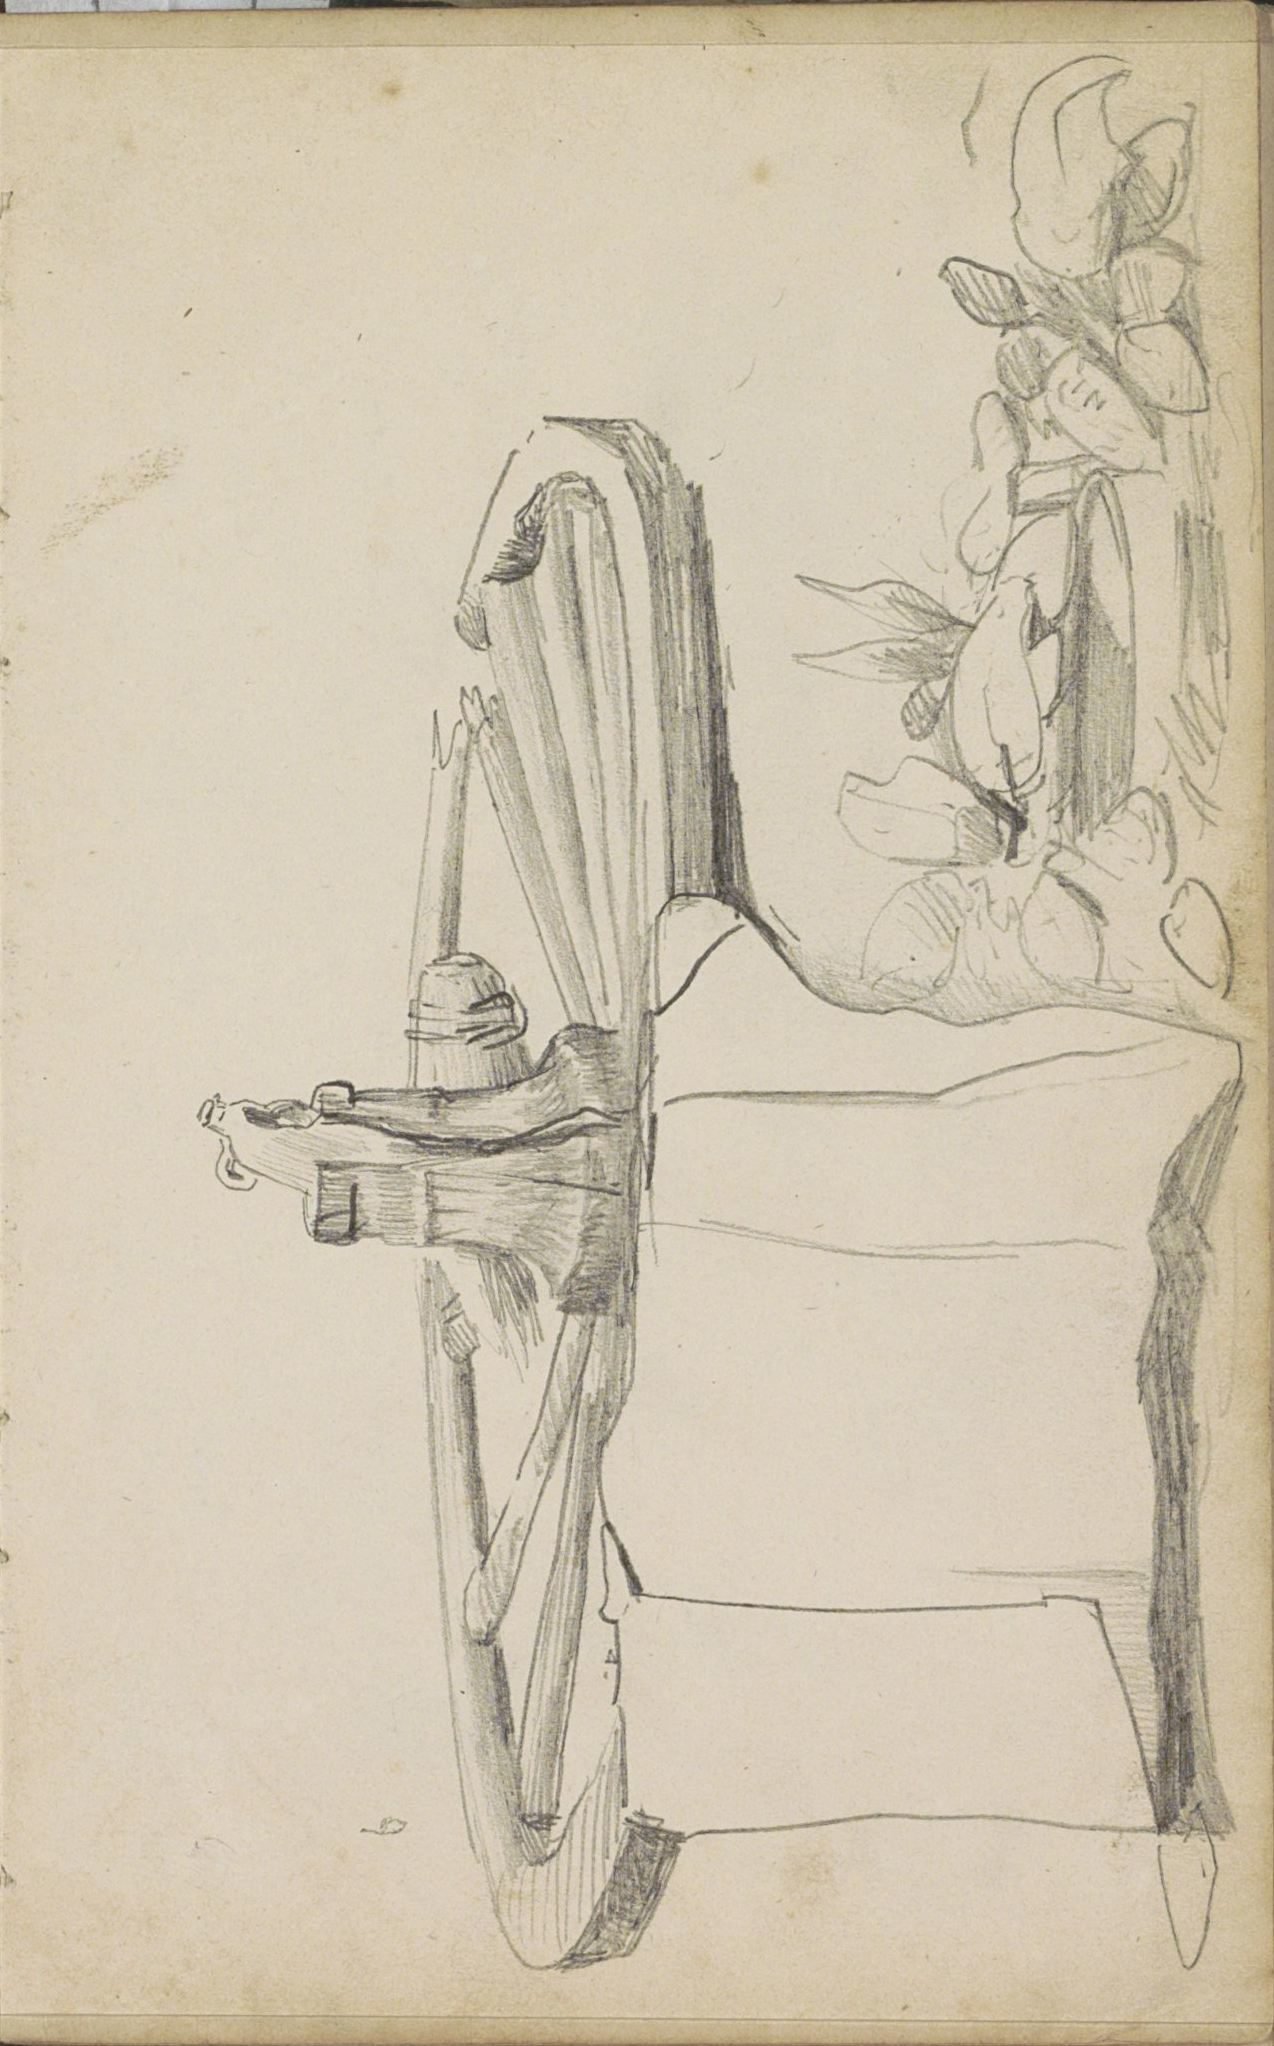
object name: sketchbook leaf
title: Wagenwiel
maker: johannes tavenraat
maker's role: draughtsman, painter, print maker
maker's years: 1809-1881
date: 1839-1872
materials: paper, pencil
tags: plants (in general), wheel (of vehicle)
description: Het wiel ligt naast een bakje met water en planten. Blad 6 recto uit een schetsboek met 73 bladen.